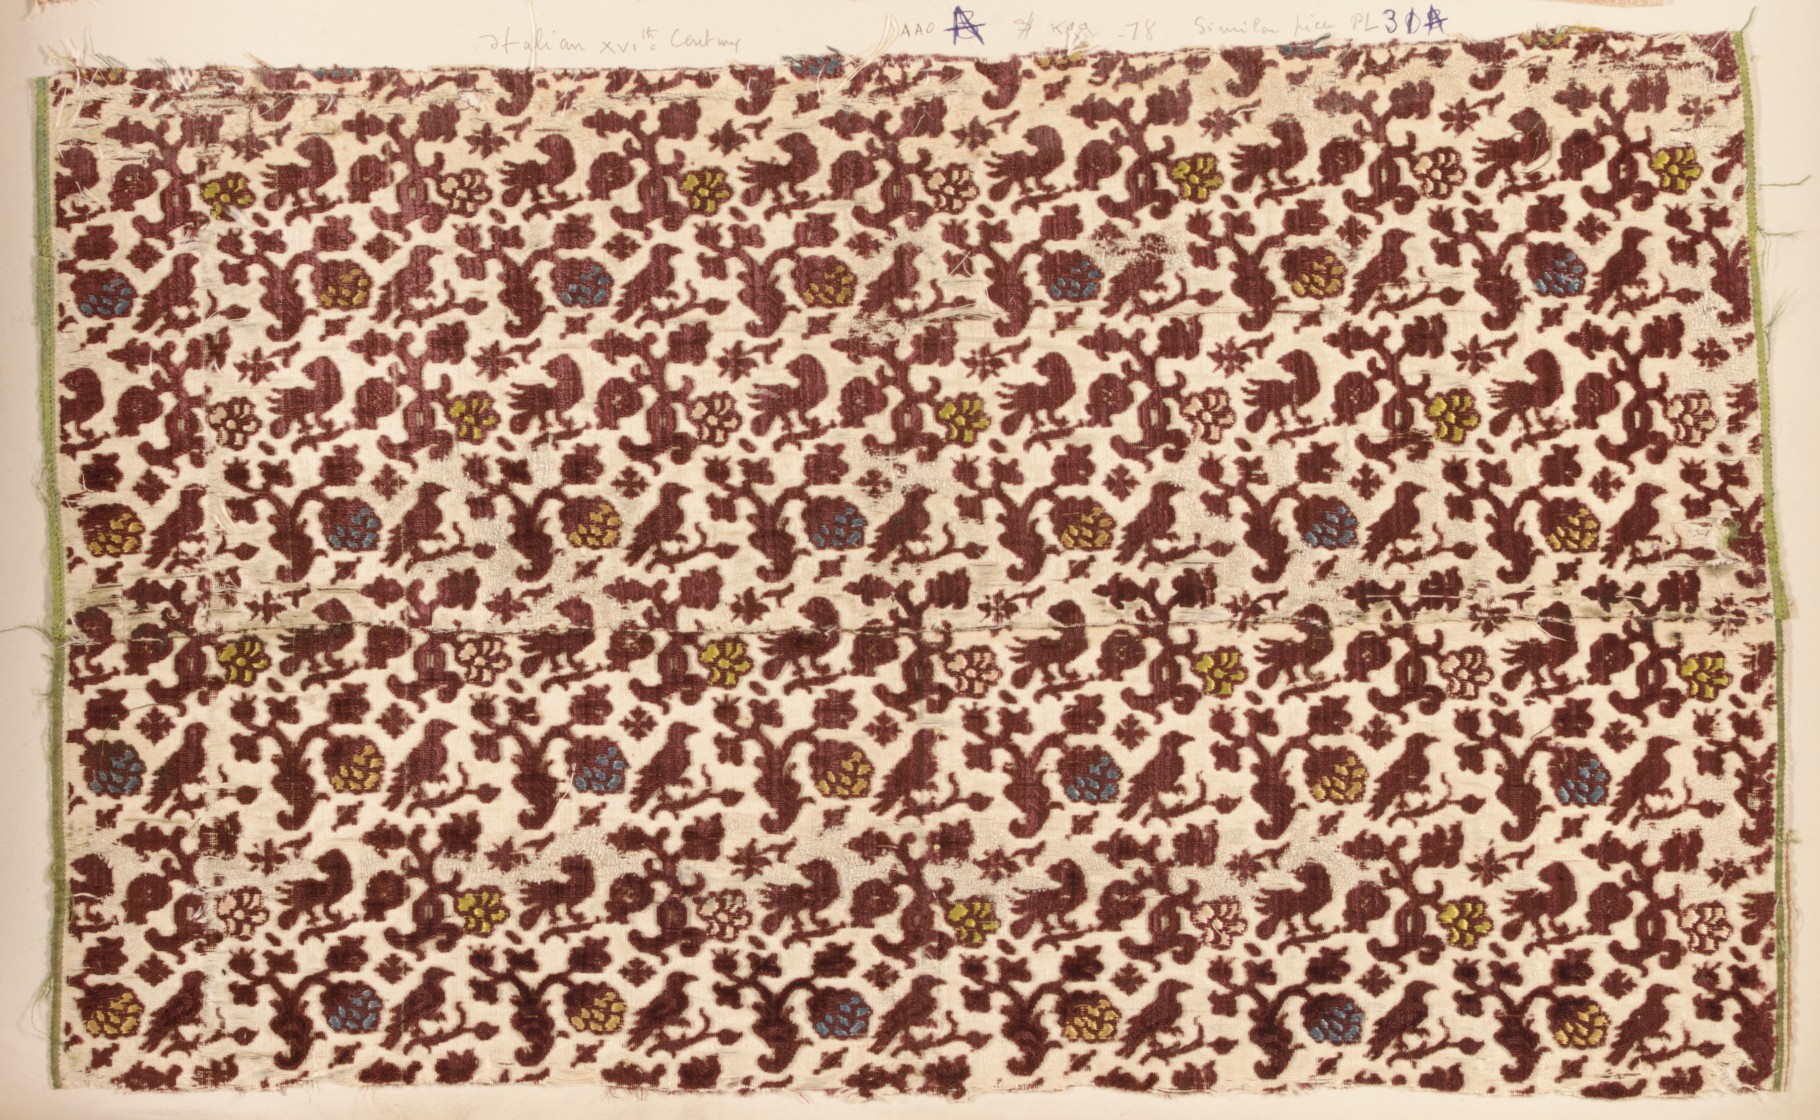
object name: fragment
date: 1501-1600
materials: silk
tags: birds,flowers